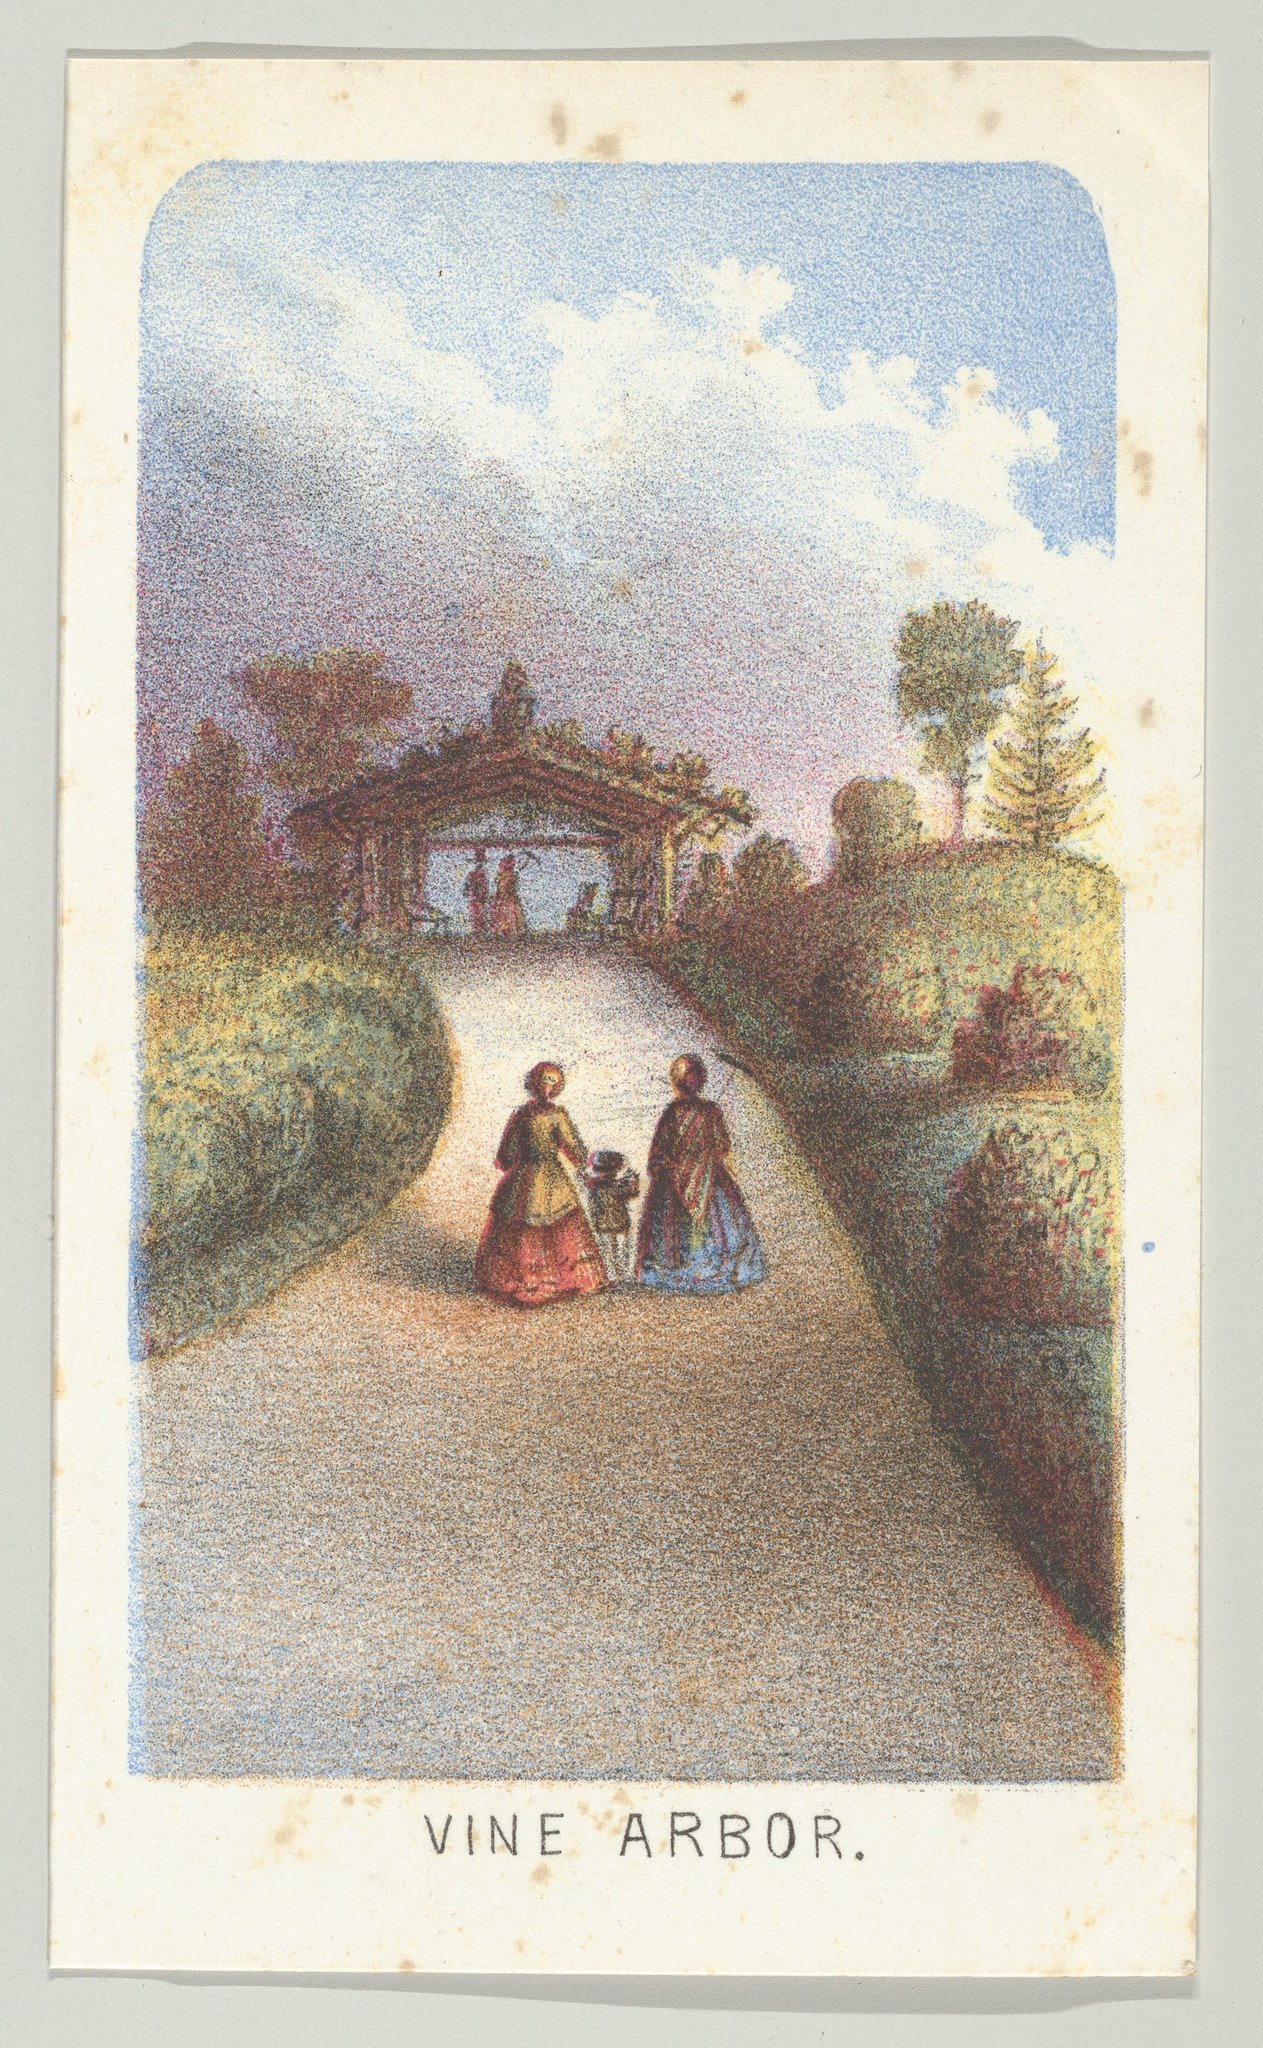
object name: print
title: Vine Arbor, from the series, Views in Central Park, New York, Part 3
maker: louis prang & co.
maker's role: publisher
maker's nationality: american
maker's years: 1800-1950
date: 1864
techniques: lithograph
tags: parks,women